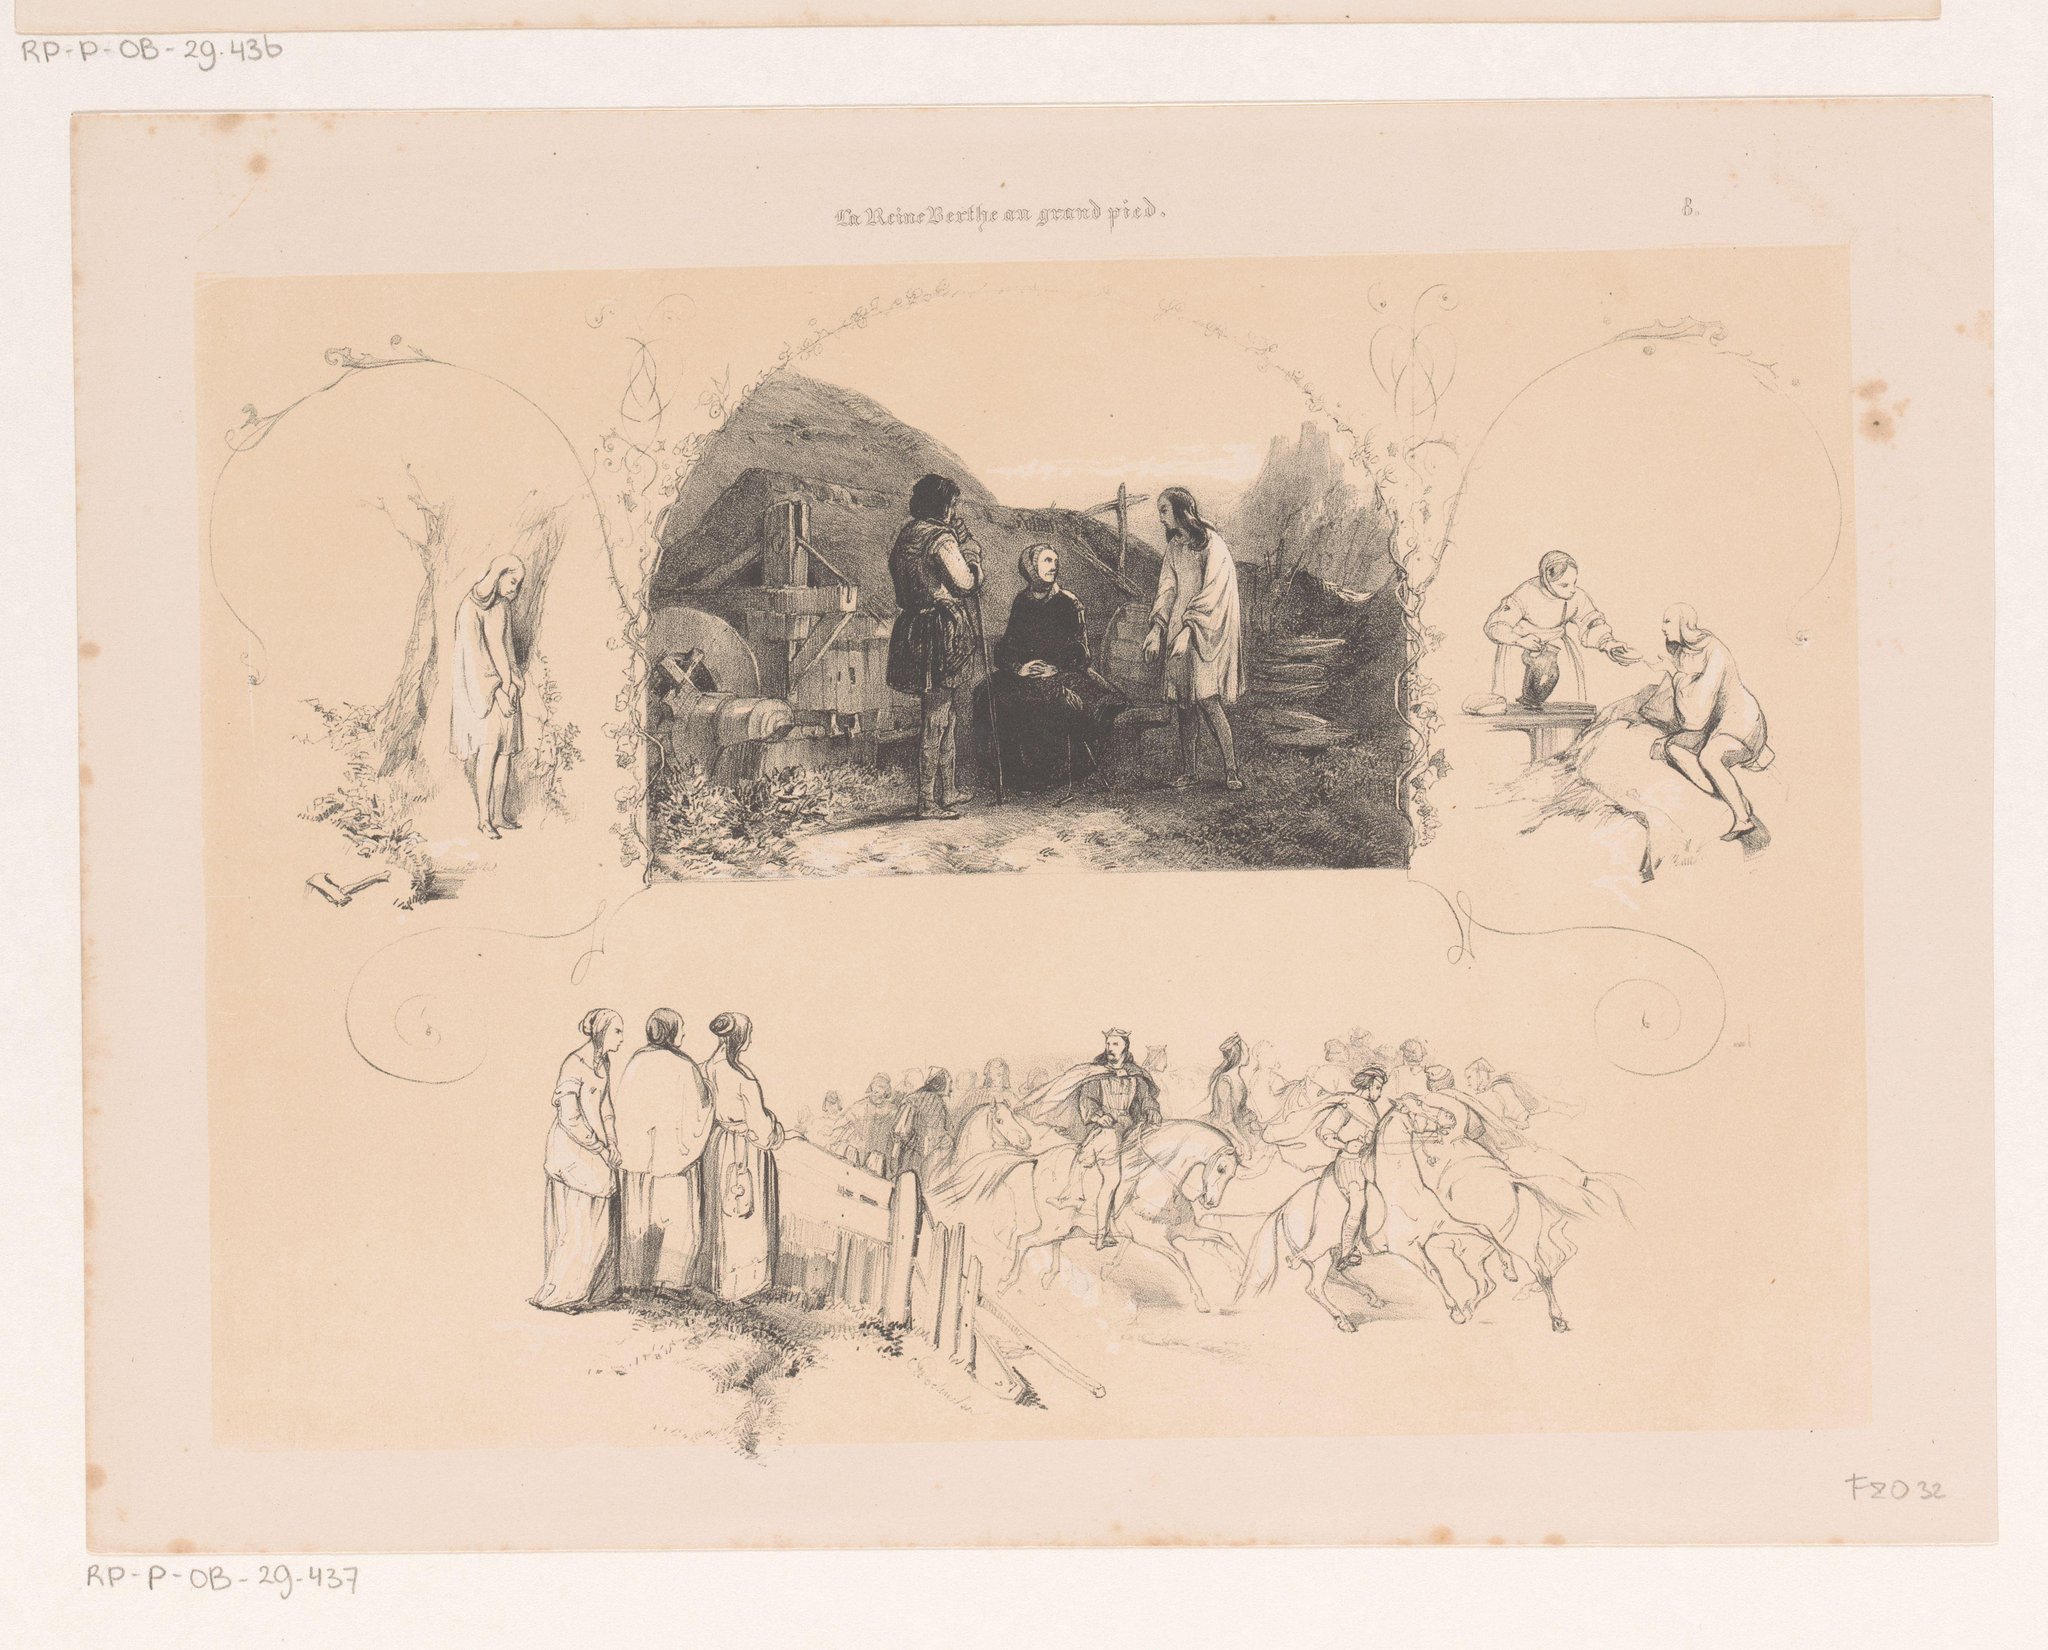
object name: book illustration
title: Vrouw in gesprek met twee mannen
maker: charles rochussen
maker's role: draughtsman, painter, print maker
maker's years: 1814-1894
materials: paper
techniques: tone lithography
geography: the hague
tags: conversation, dialogue; conversation piece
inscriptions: collector's mark: Lugt 2228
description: Prent uit: Plancy, Jacques Collin de. La Reine Berthe au grand pied. Den Haag: Nederlandsche Maatschappij van Schoone Kunsten, 1842.